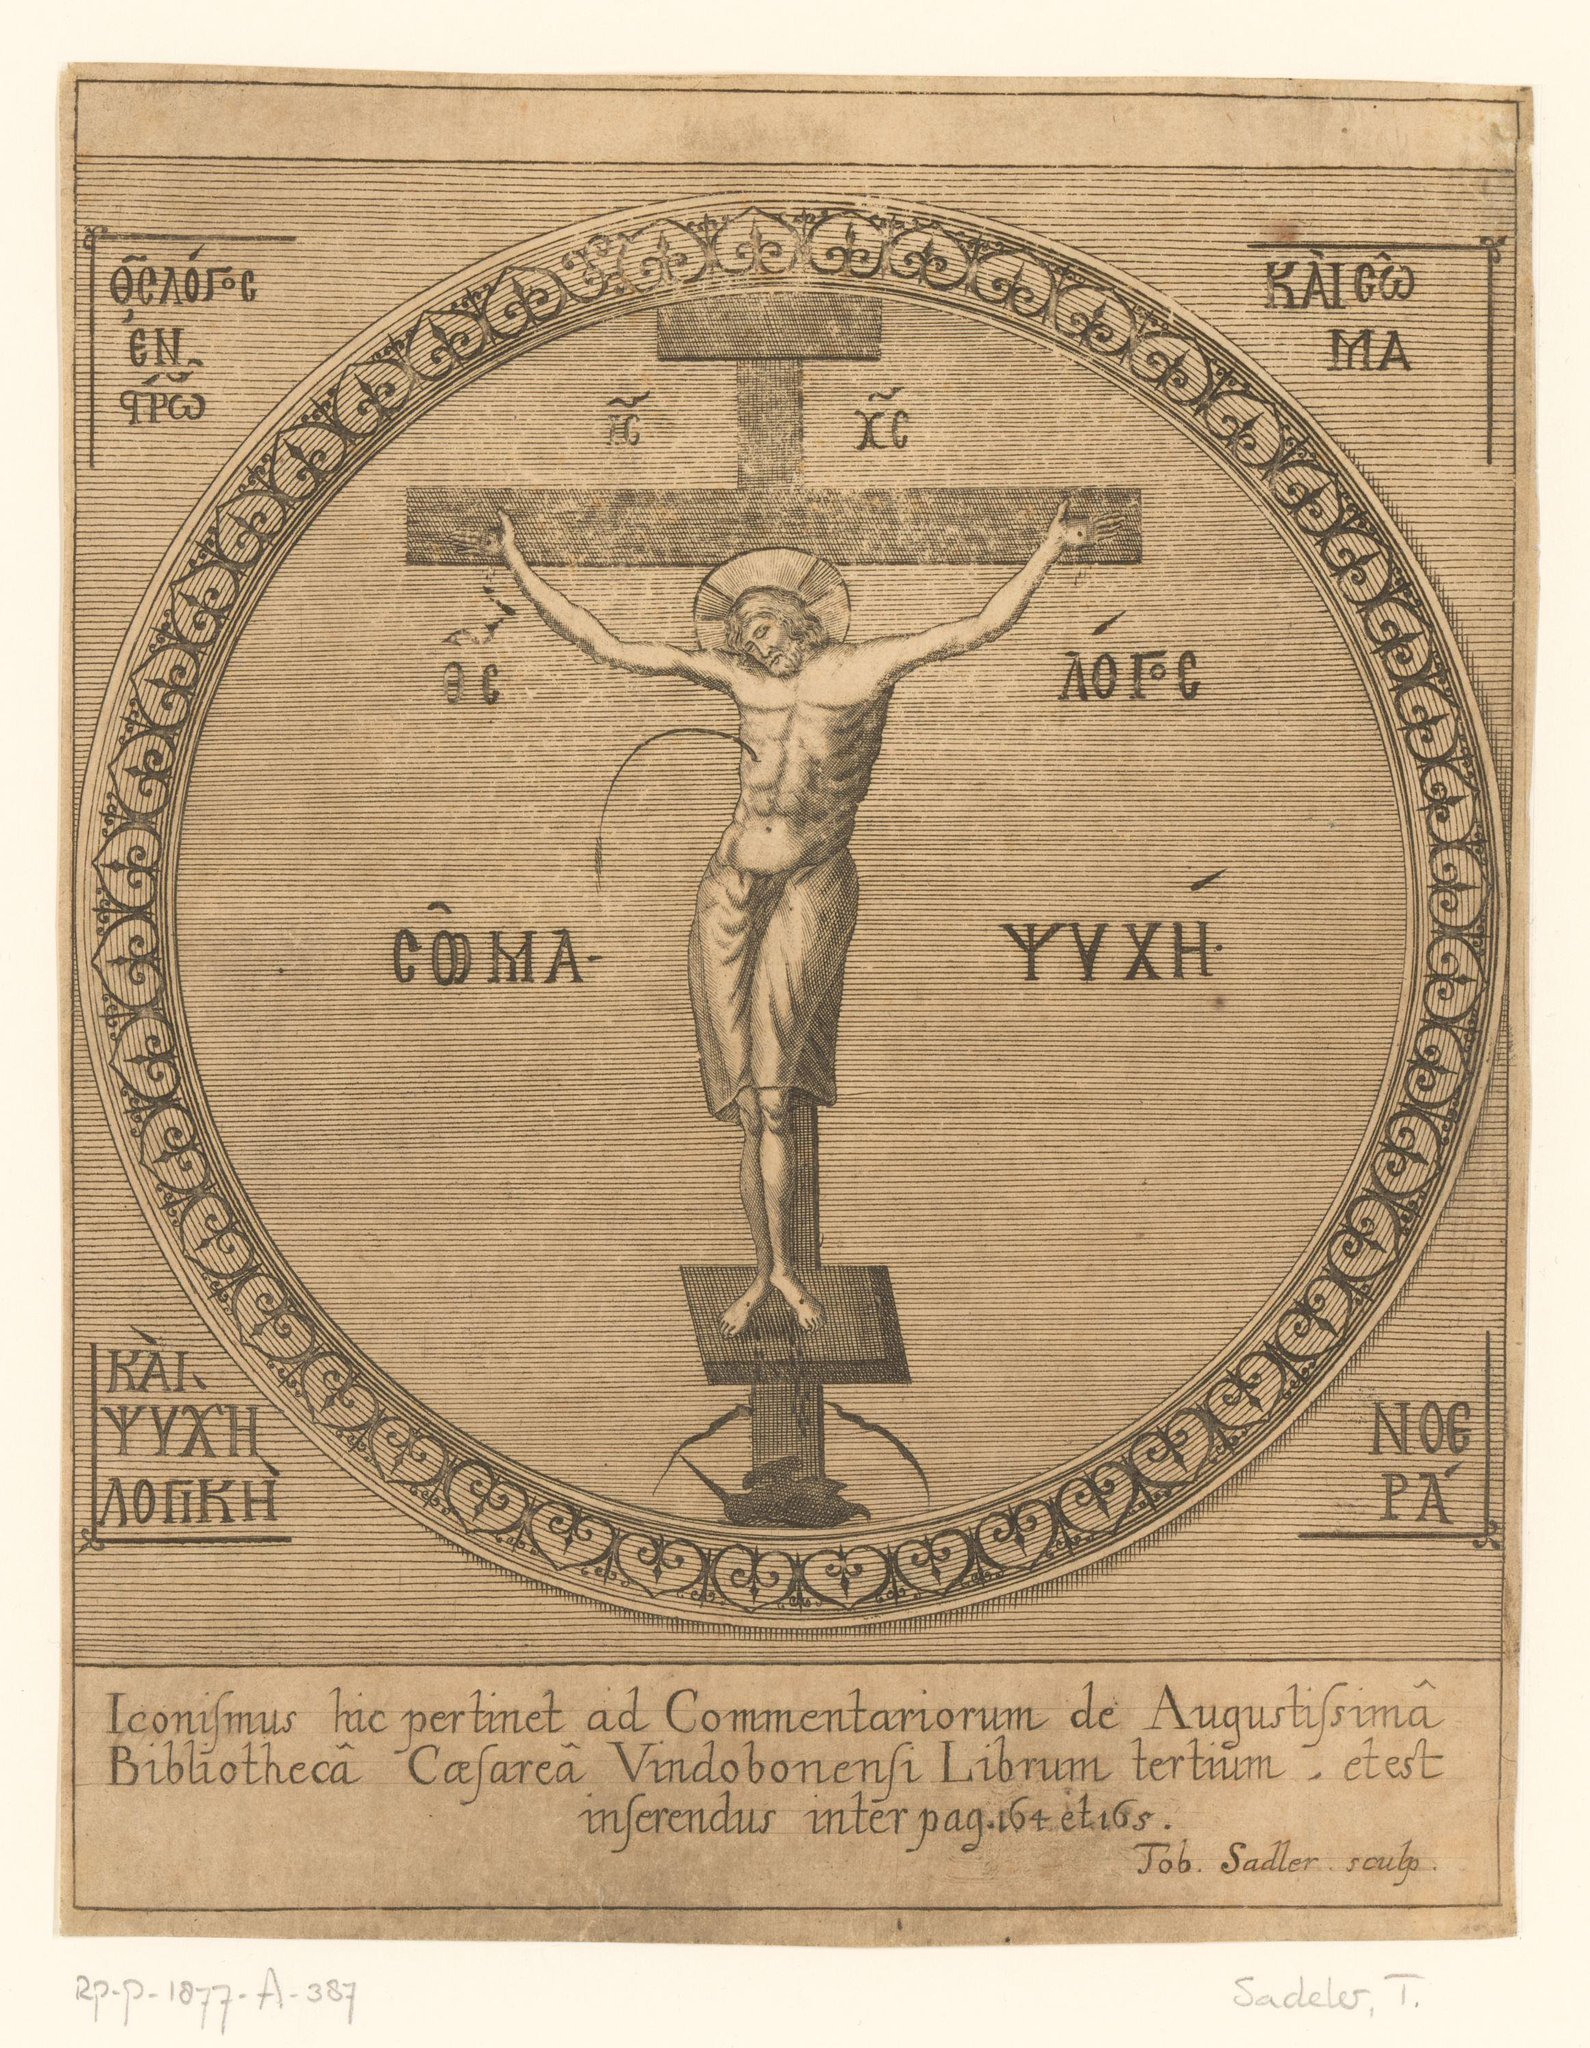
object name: print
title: Christus aan het kruis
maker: tobias sadeler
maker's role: print maker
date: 1670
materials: paper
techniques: engraving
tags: comprehensive representations of the events on golgotha during christ's hanging on the cross, no particular event emphasized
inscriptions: collector's mark: Lugt 1425, collector's mark: Lugt 2228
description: Prent ook gebruikt in: Lambeck, Peter. Commentarium de Augustissima Bibliotheca Caesarea Vindobonensi (...). Wenen: Matthaeus Cosmerovius, 1670. Dl. 3.